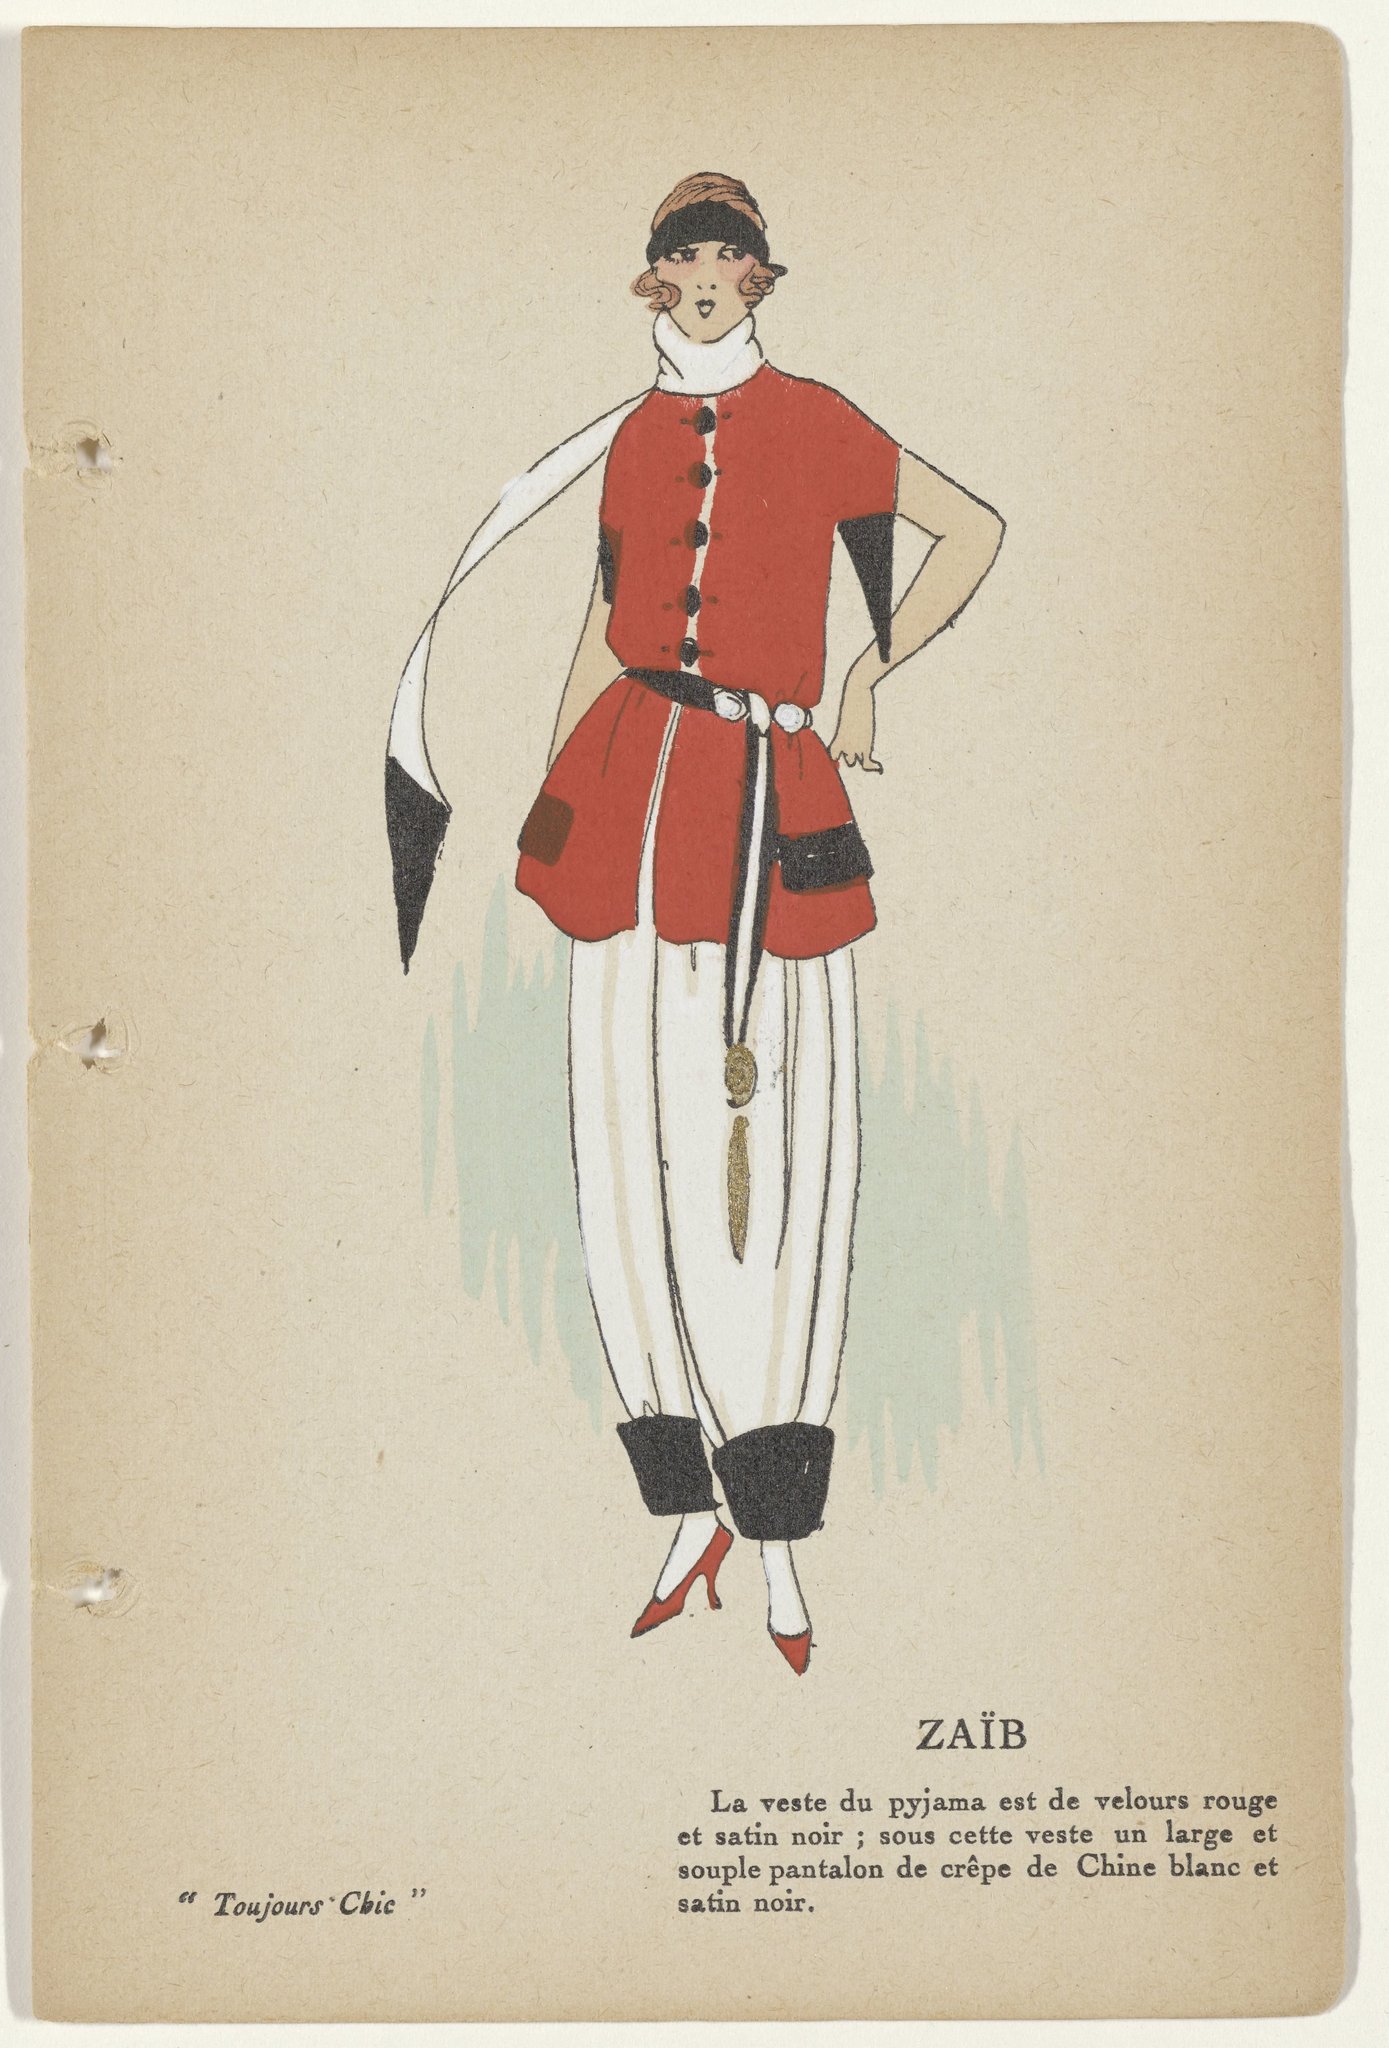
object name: fashion print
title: Toujours Chic Les Deshabillés, Hiver 1921-1922: Zaïb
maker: g-p. joumard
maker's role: publisher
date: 1921-1922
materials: paper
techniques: letterpress printing, pochoir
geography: paris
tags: fashion plates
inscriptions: date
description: Prent uit Catalogus "Toujours Chic" waarin een overzicht van de wintermode 1921-1922.